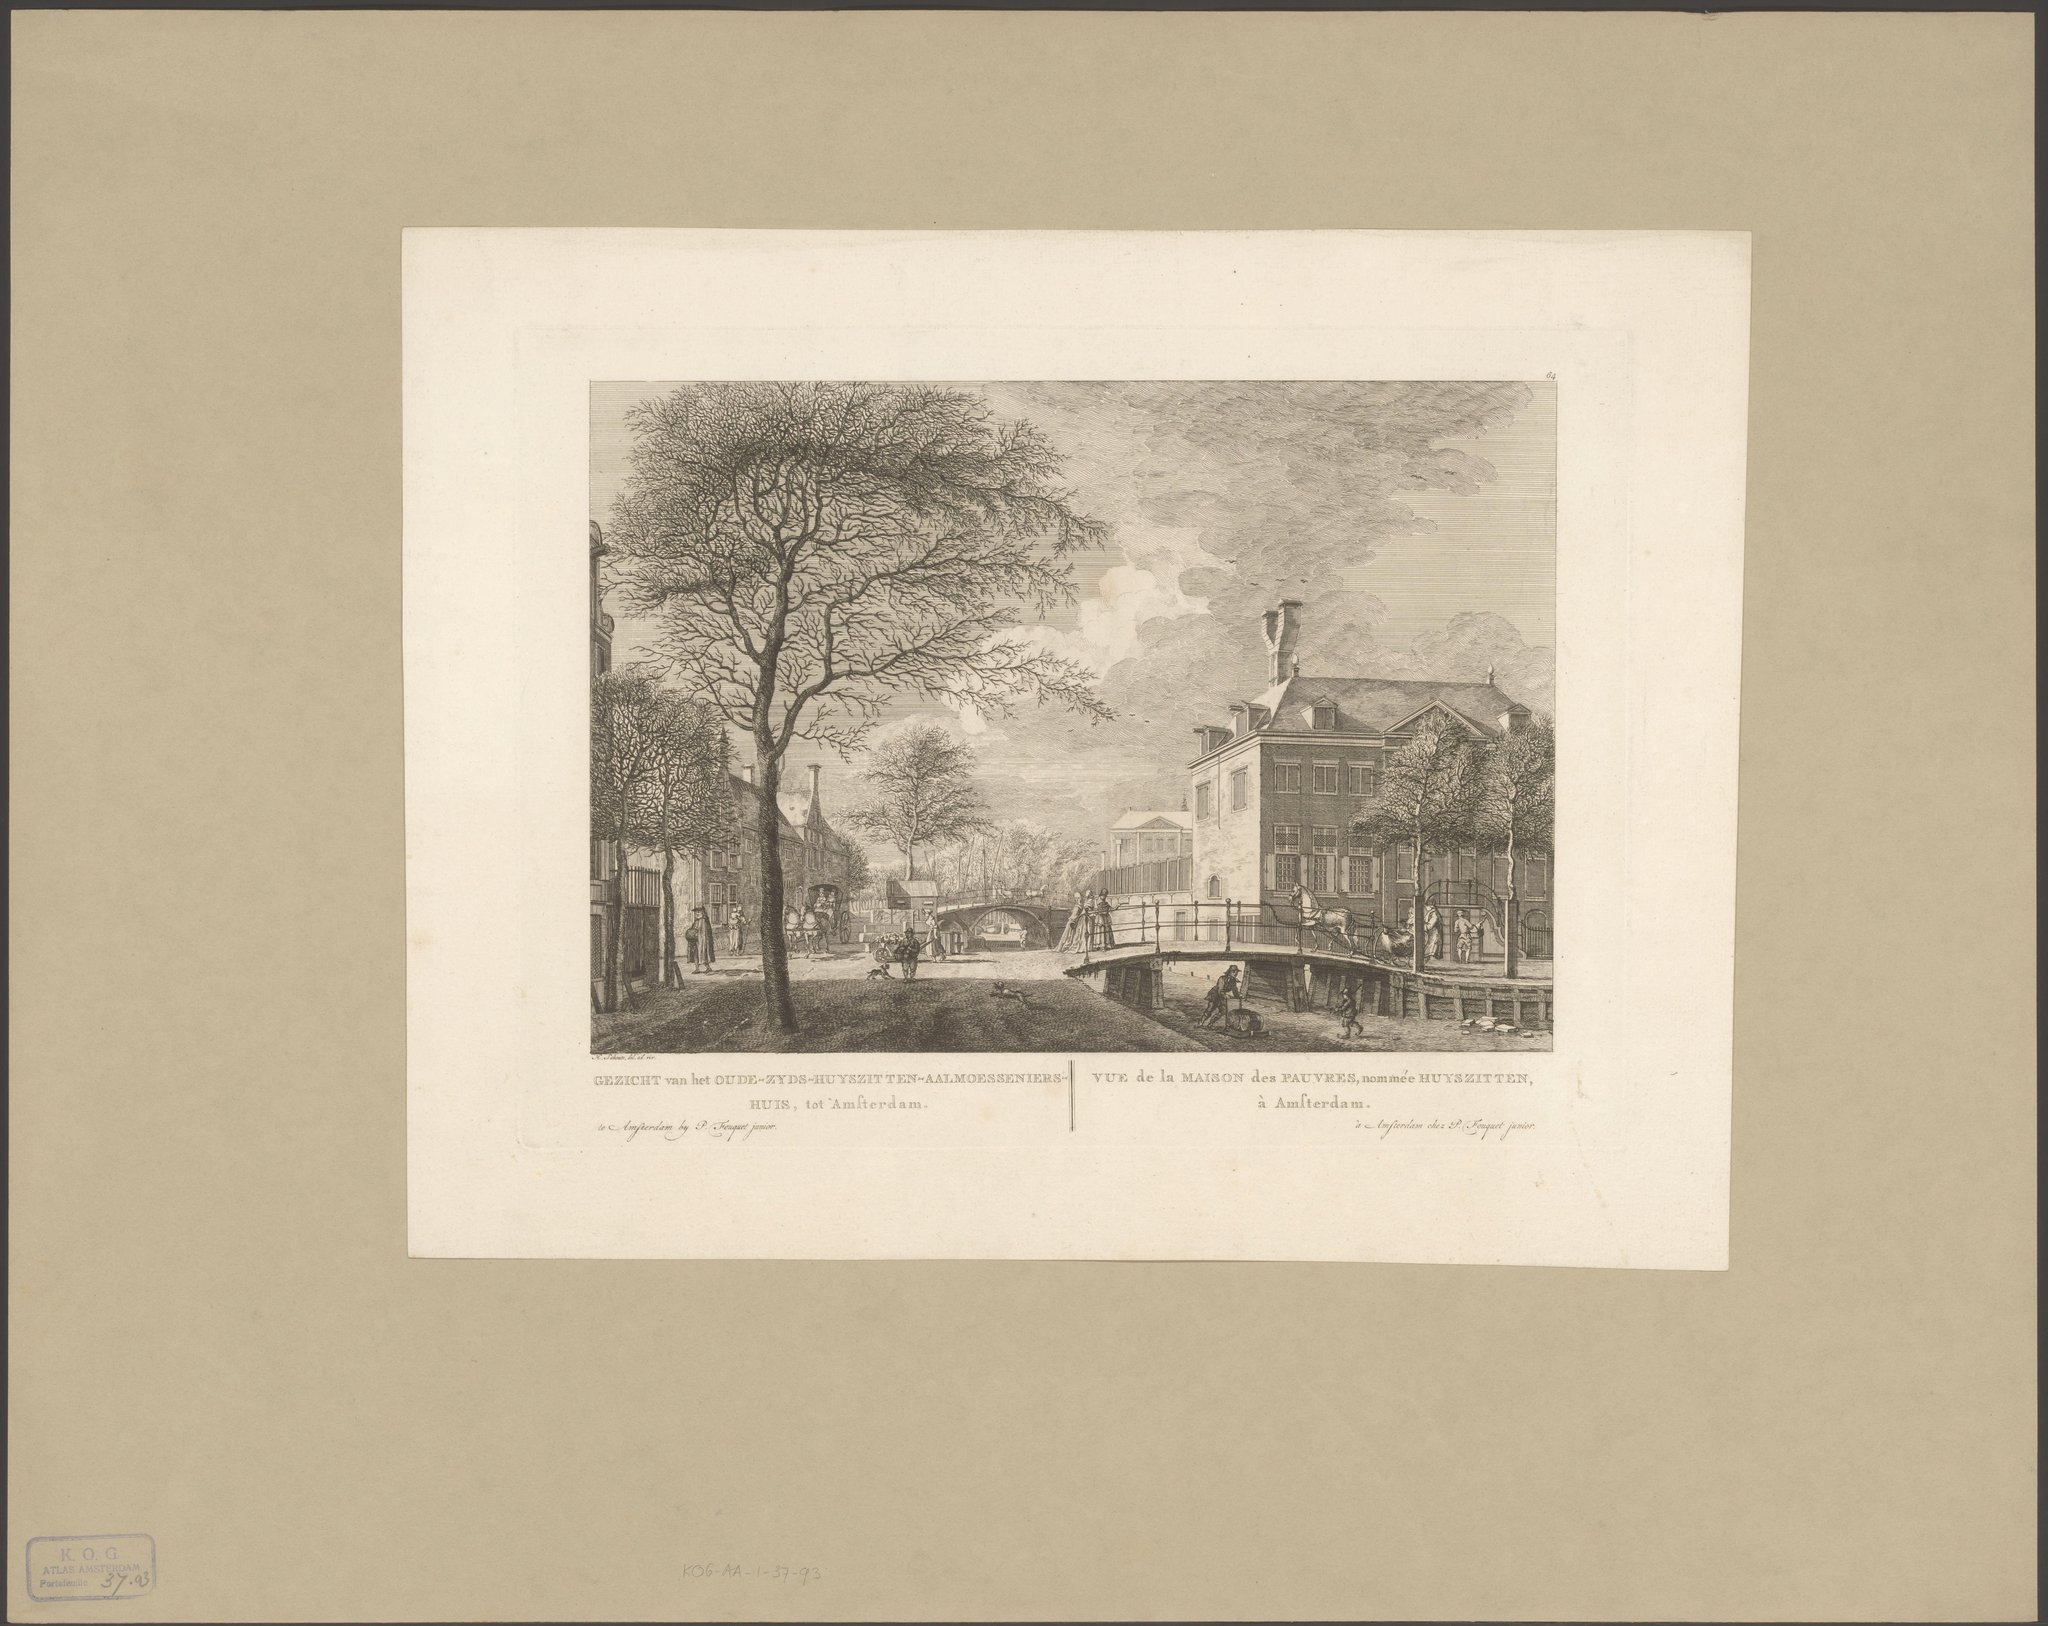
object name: print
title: Gezicht van het Oude-zyds-huyszitten-aalmoesseniers-huis, tot Amsterdam / Vue de la Maison des Pauvres, nommée Huyszitten, à Amsterdam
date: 1770-1783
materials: paper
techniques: engraving, etching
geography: amsterdam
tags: bridge in city across river, canal, etc. (+ city(-scape) with figures, staffage), poorhouse, skates (winter sports), canals, waters (in city) (+ city(-scape) with figures, staffage)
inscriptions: collector's mark: Lugt 1641b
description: Vanaf 1760 gaf Pierre Fouquet stadsgezichten van Amsterdam naar tekeningen van verschillende kunstenaars uit. Deze prenten werden aanvankelijk los verkocht. Later werden ze samengebonden verkocht in verschillende volgordes en aantallen in: (1). Afbeeldingen van de wyd-vermaarde koopstad Amsterdam benevens des zelvs voornaamste gebouwen en gezigten alle naar het leeven getekend / Receuil des edifices les plus considerables et des plus belles vues, de la fameuse ville d'Amsterdam, dessinées d'après nature. Amsterdam: Pierre Fouquet, 1778-1783. Deze 'uitgave' bestond waarschijnlijk alleen uit een titelblad en inhoudsopgave van de tot dusver 100 uitgegeven prenten, die de koper zelf aan zijn of haar reeds verzamelde prenten kon toevoegen. De hoeveelheid en volgorde van prenten verzameld onder deze titel verschilt dus sterk. (2). Nieuwe atlas, van de voornaamste gebouwen en gezigten der stad Amsterdam, met derzelver beknopte beschryvingen. 2 dln. Amsterdam: Daniël Jean Changuion en Petrus den Hengst [in opdracht van Pierre Fouquet], 1783. Ook werden er door verschillende uitgevers tussen 1788 (Amsterdam: Petrus Conradi) en 1805 (Amsterdam: Evert Maaskamp) heruitgaven gepubliceerd.